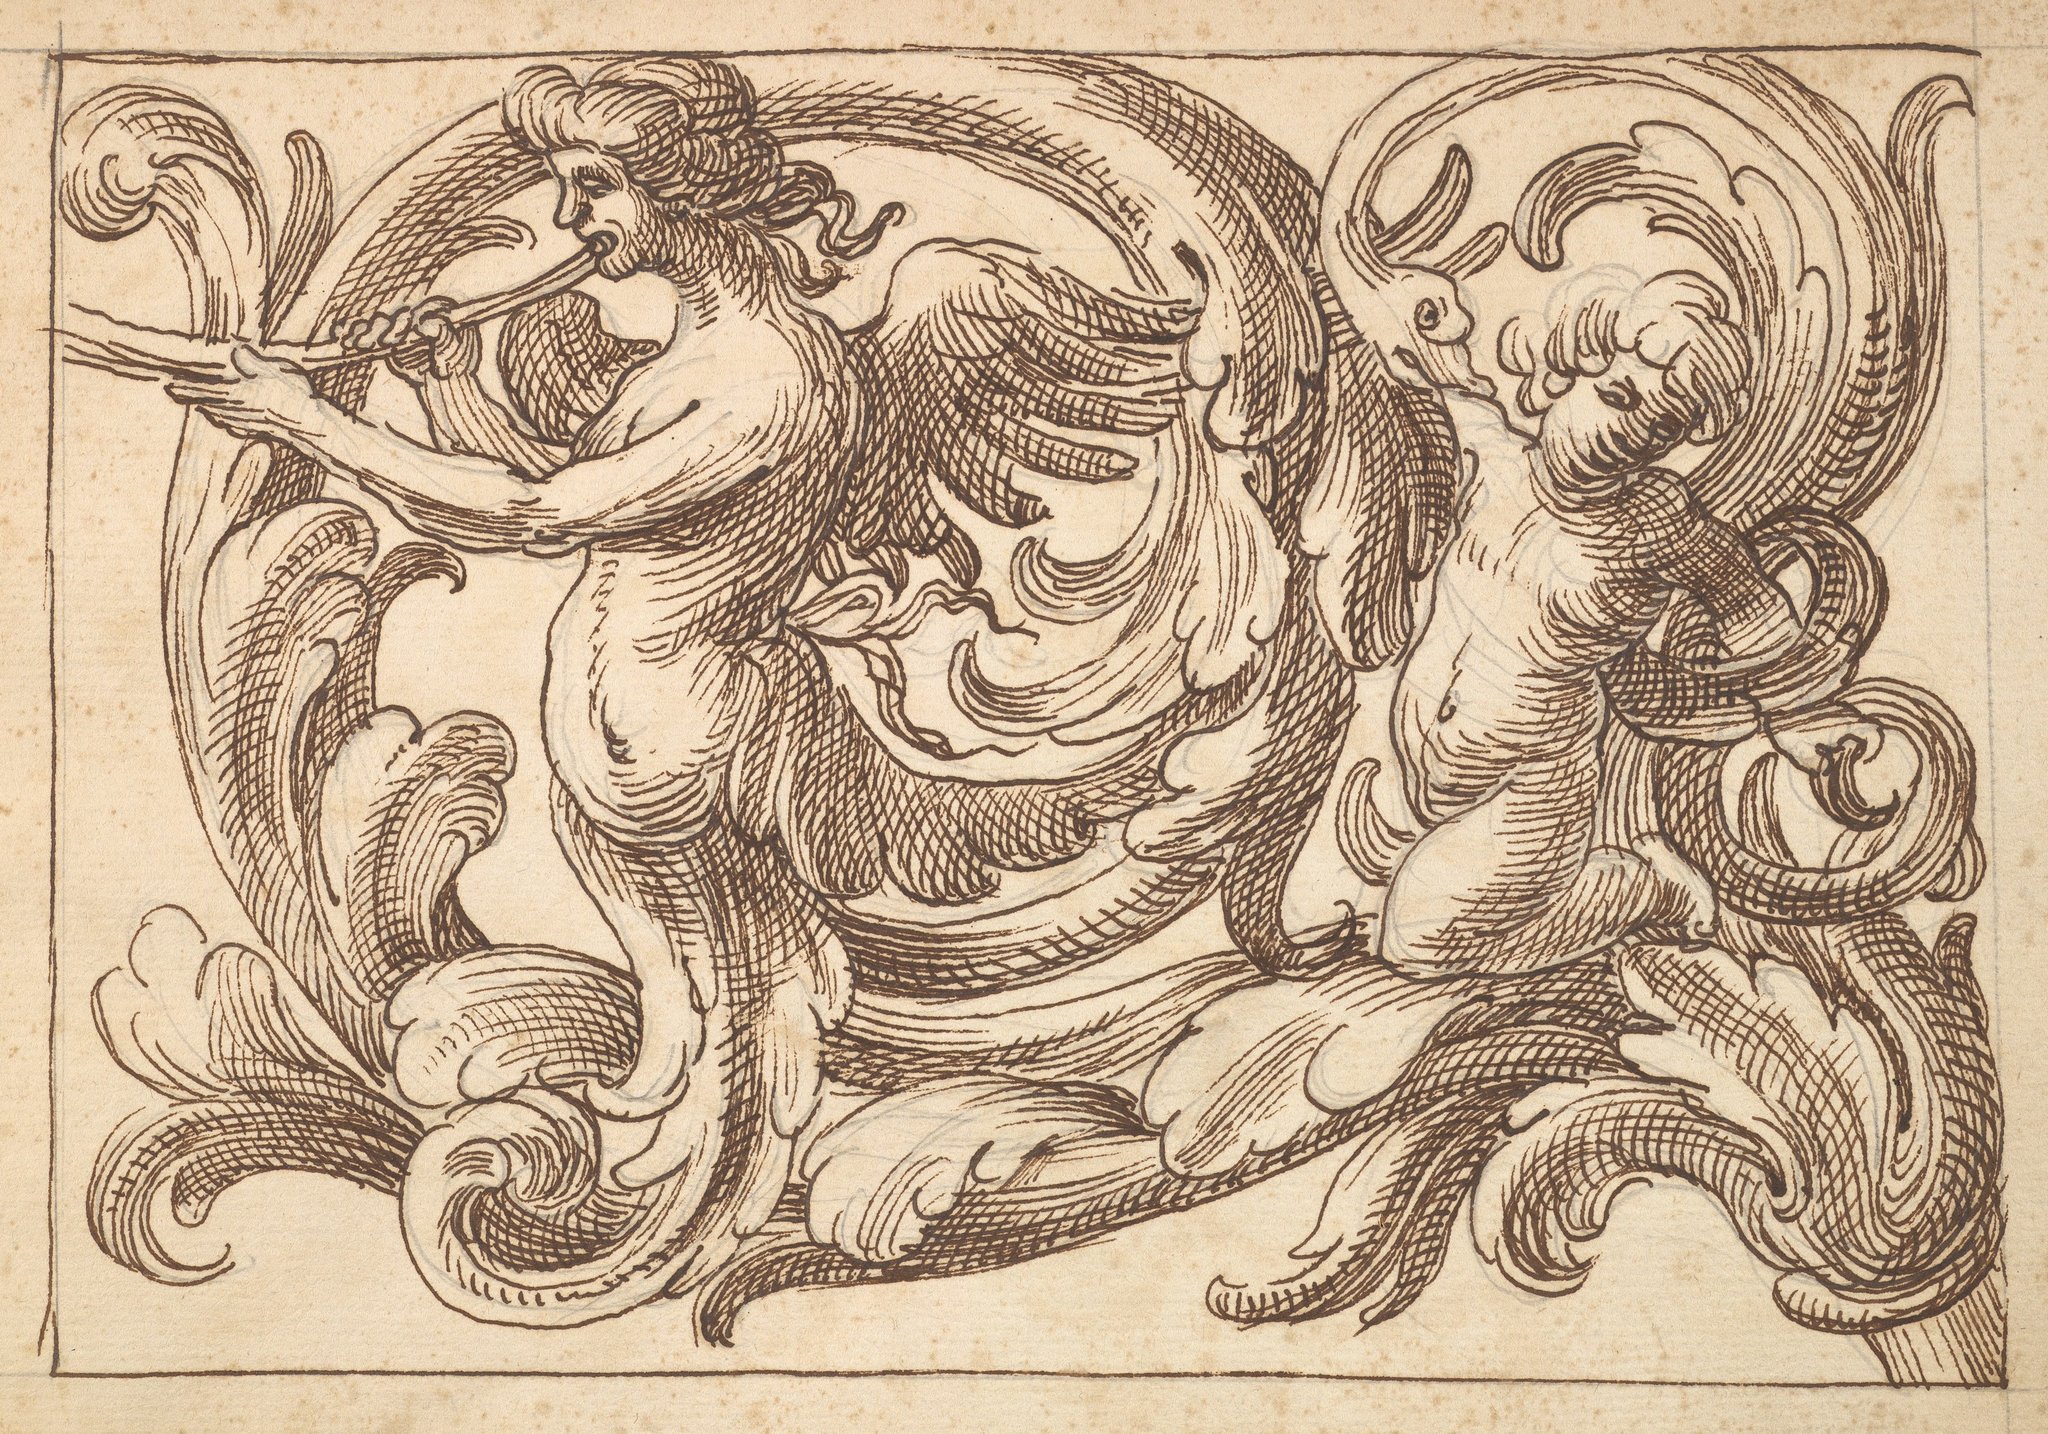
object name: collection ornament architecture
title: Horizontal Panel Design with a Male Figure, a Putto and a Snake Interspersed between Acanthus Rinceaux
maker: anonymous, italian, venetian, 17th century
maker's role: artist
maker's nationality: italian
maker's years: 1600-1700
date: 1601-1700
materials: ink, drawing material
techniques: pen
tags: snakes